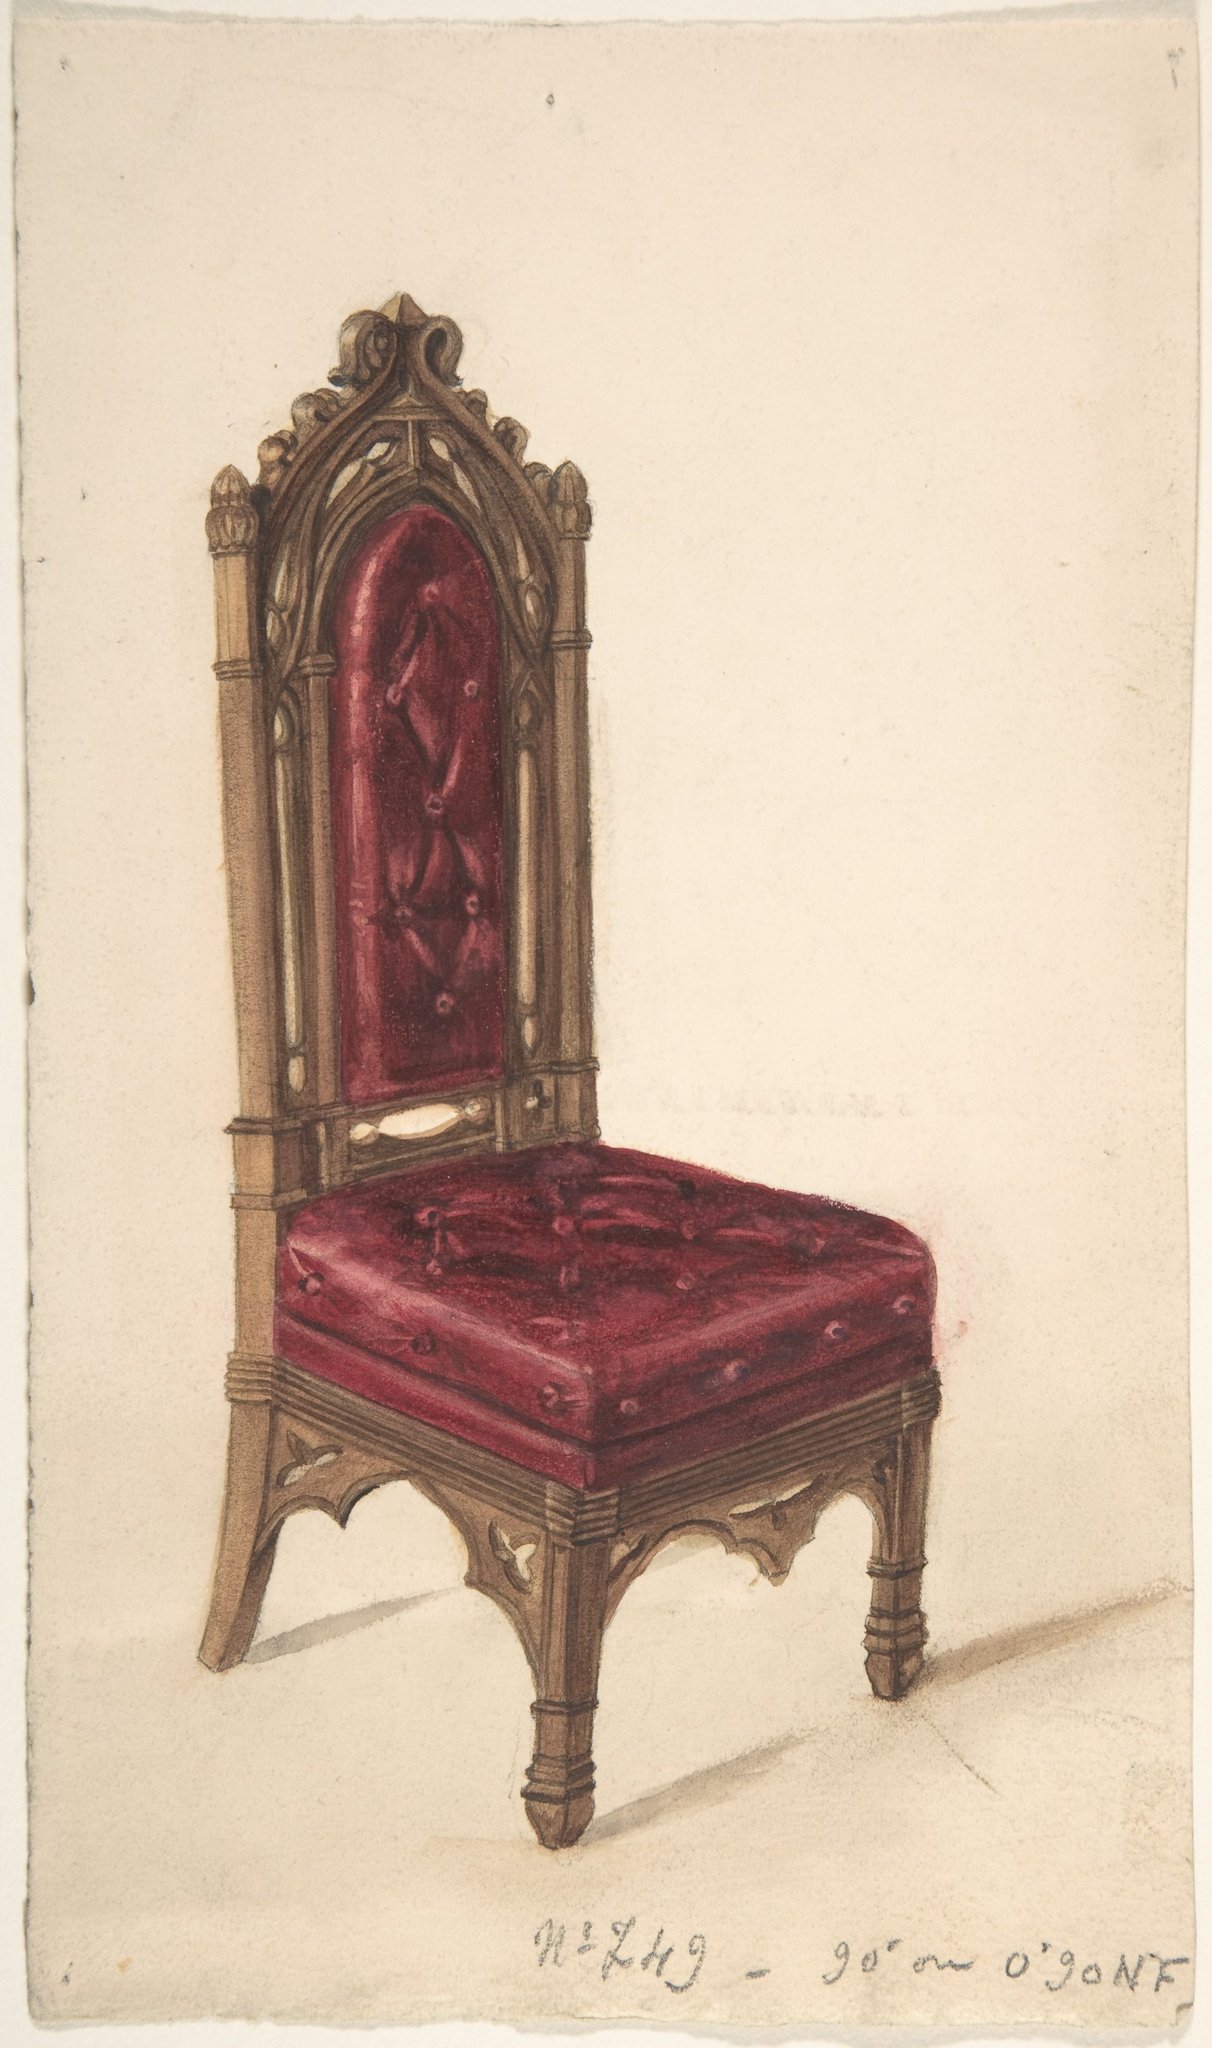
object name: drawing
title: Gothic Style Chair with Dark Wood Frame and Maroon Upholstery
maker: anonymous, british, 19th century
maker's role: artist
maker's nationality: british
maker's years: 1800-1900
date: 1801-1900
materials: watercolor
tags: chairs